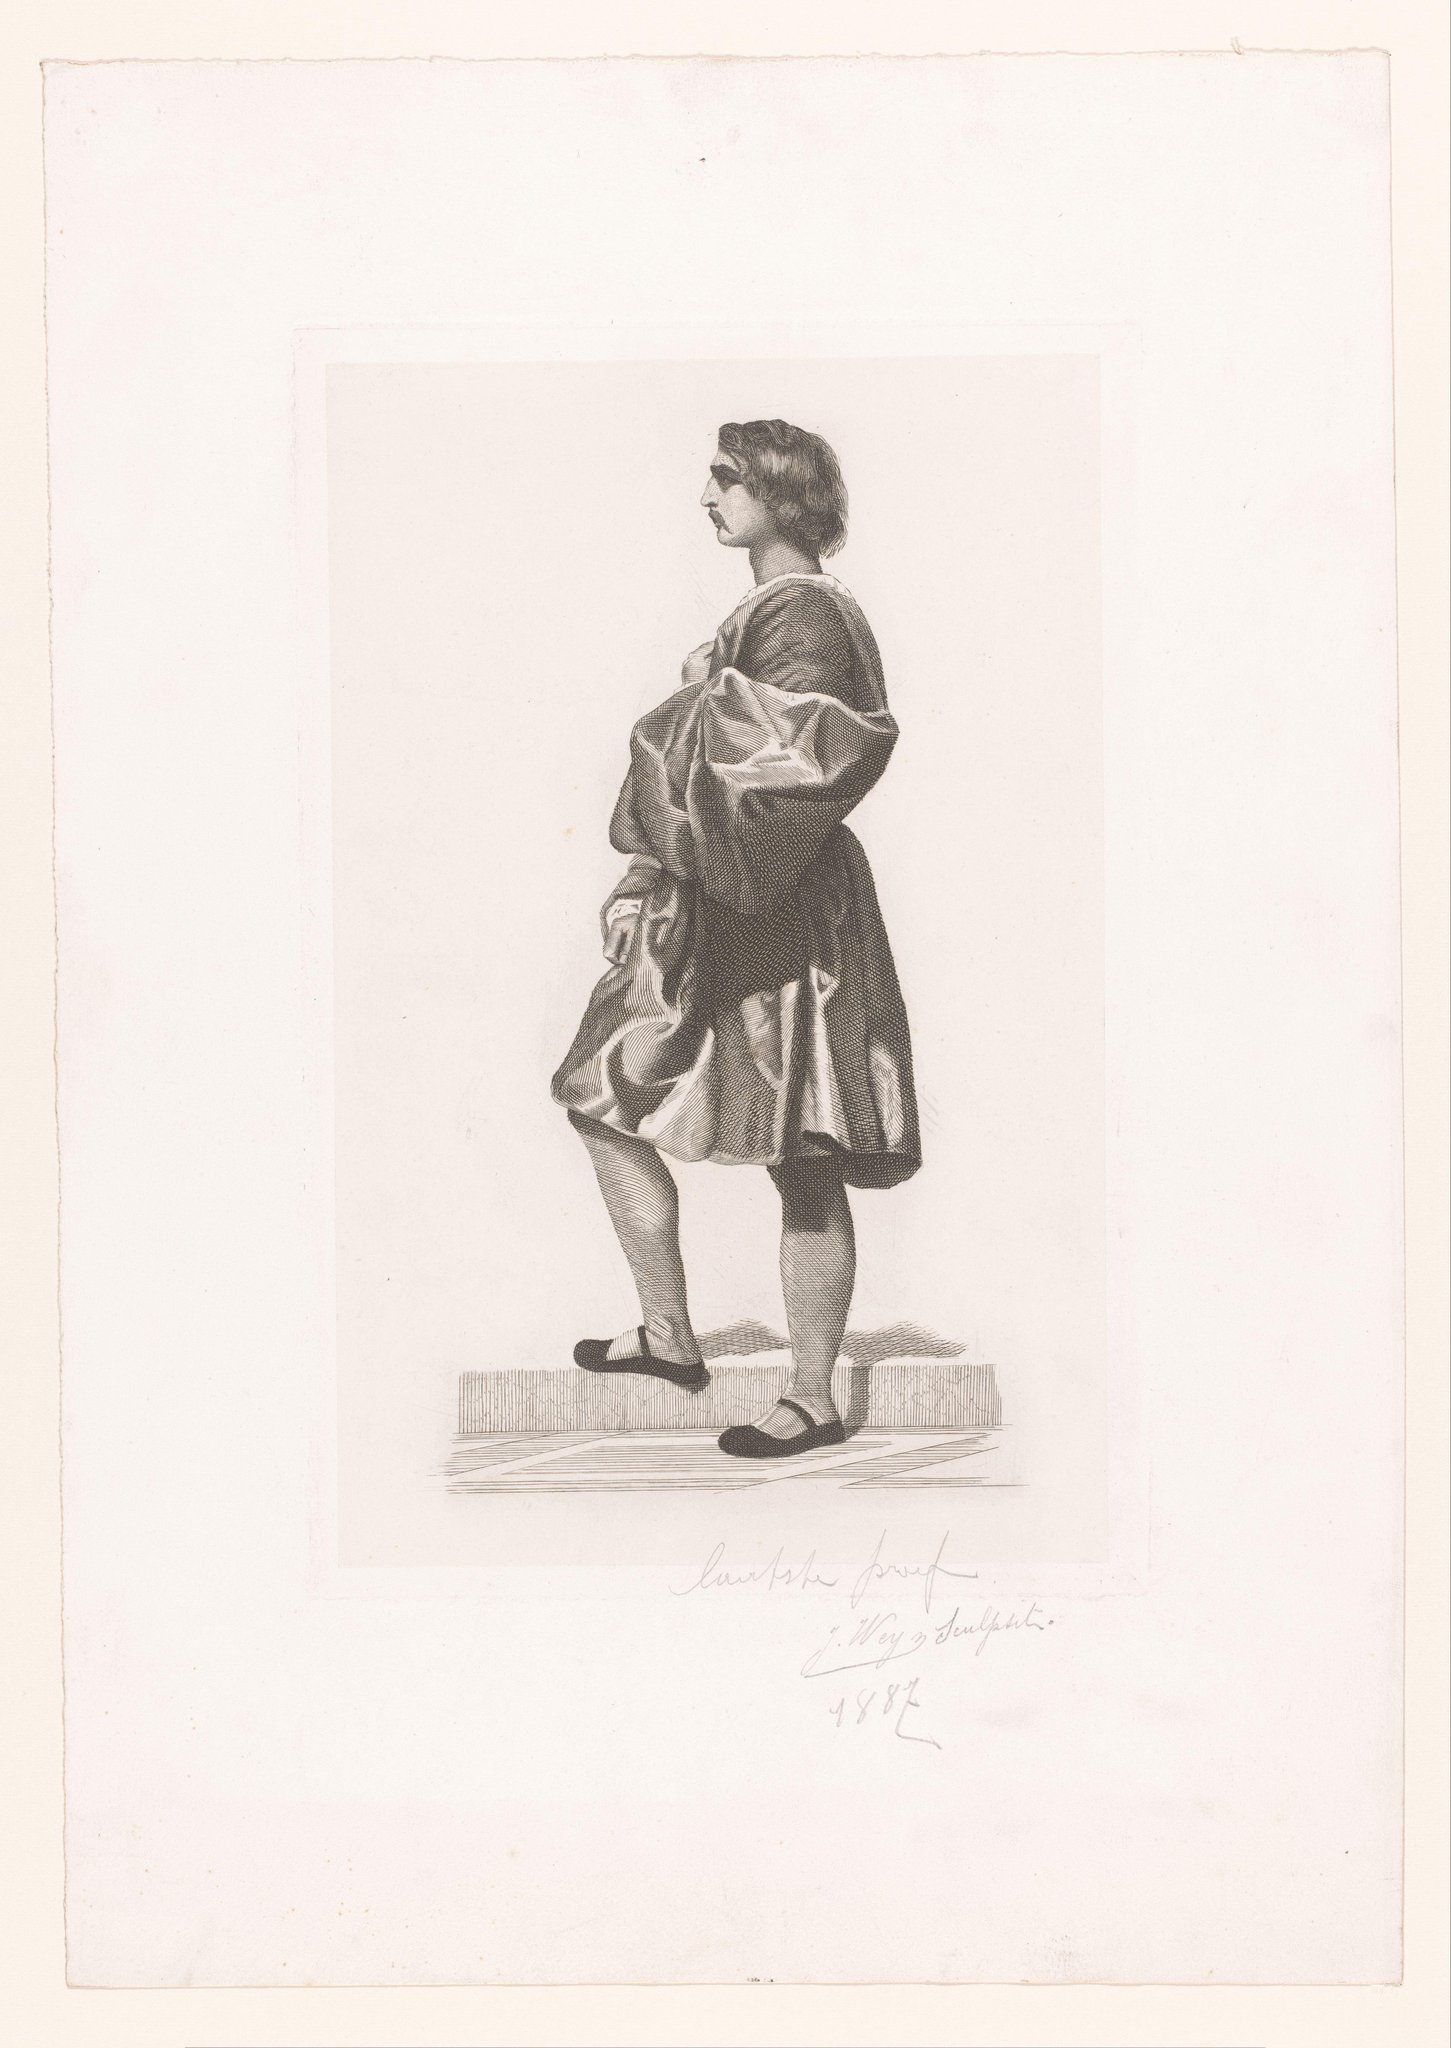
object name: print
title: Page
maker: j. weyn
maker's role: print maker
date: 1887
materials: paper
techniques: engraving, etching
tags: adult man, page ~ court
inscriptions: collector's mark: Lugt 2228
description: Sterfdatum van de prentmaker is onbekend. Daarom is voor de bepaling van de rechten van dit object gebruik gemaakt van de verwervingsdatum Rijksmuseum Amsterdam.